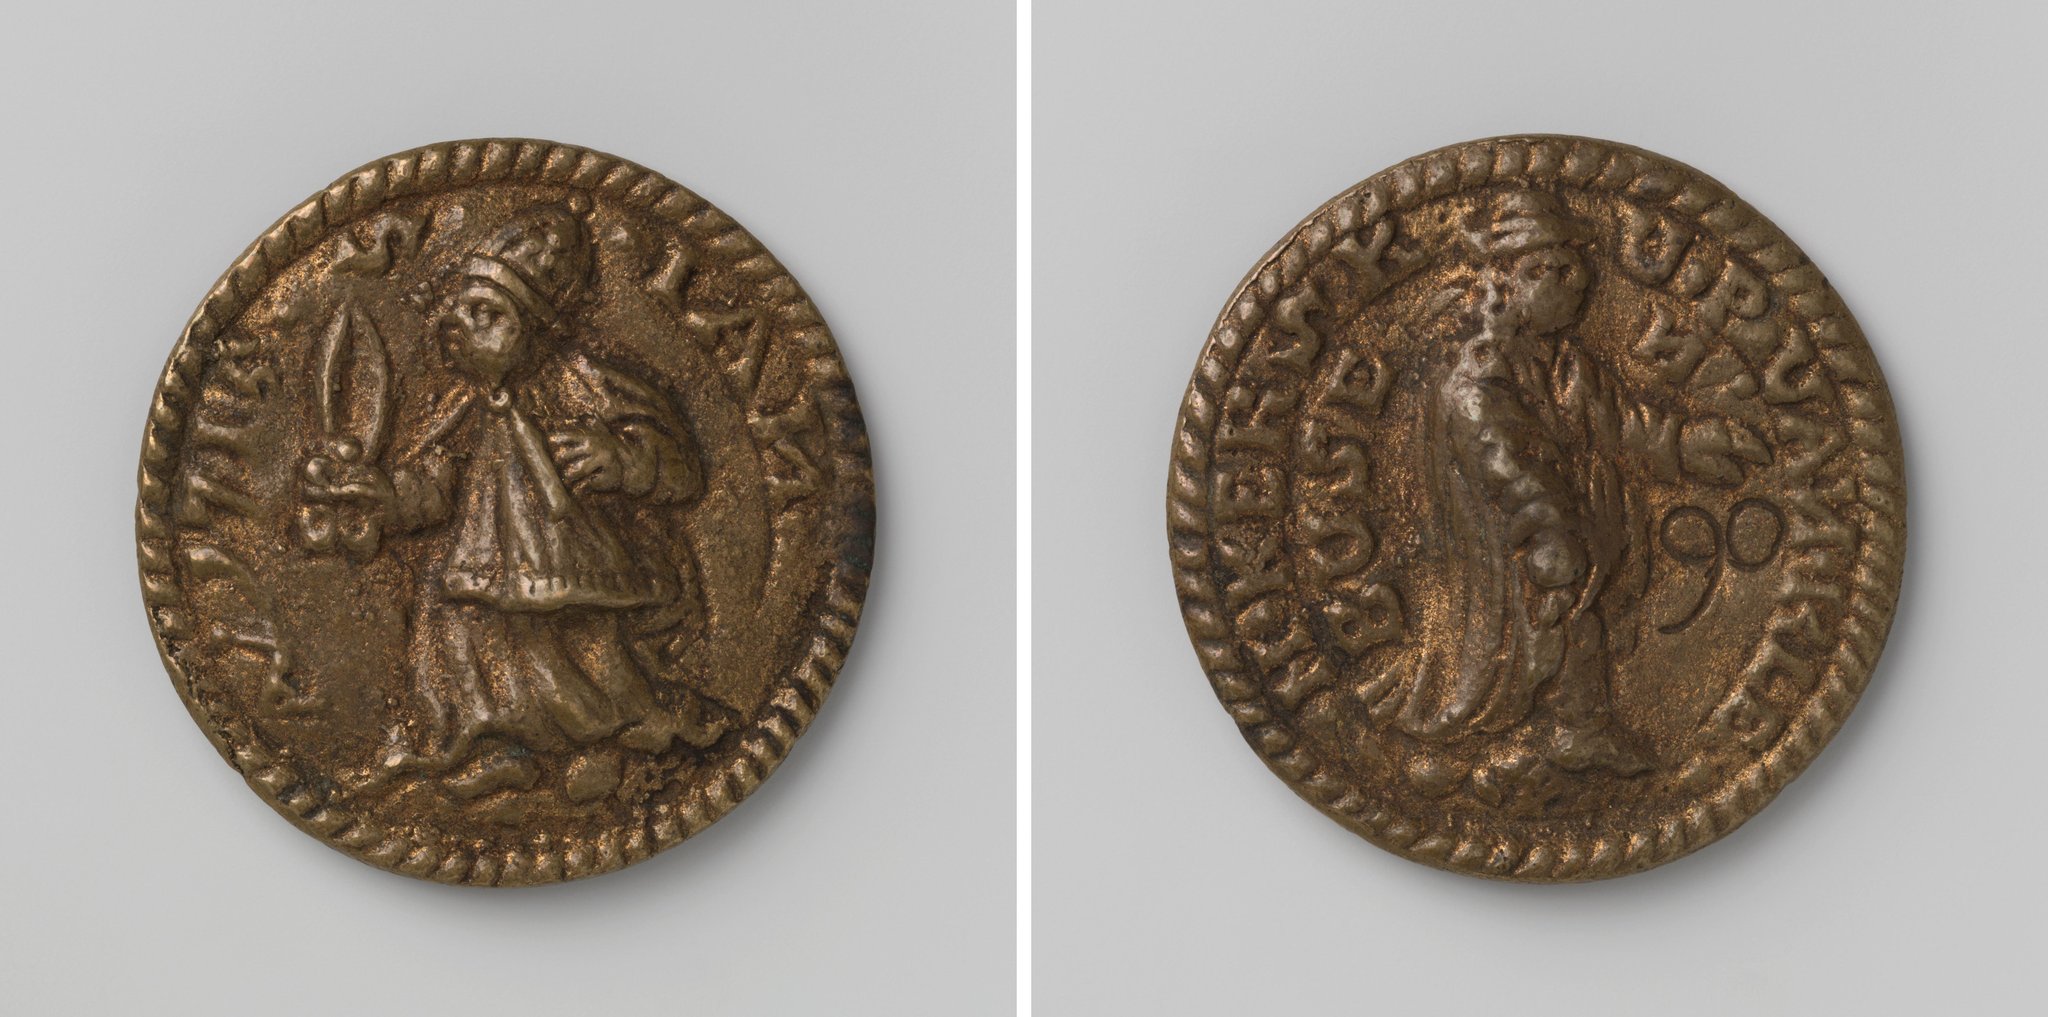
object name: medal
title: Begrafenisbus van de knechts van het kleermakersgilde van 's-Gravenhage, buspenning met no. 90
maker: Anonymous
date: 1715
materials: brass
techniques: casting, engraving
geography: the hague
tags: the hague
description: Messing penning. Voorzijde: naar links gewende bisschop St. Jan met omhoog gestoken, geopende schaar in rechterhand binnen omschrift. Keerzijde: naar rechts gewende man in rouwkleed met uitgestrekte linkerhand binnen tweeregelig omschrift; in veld rechts onder: cijfer 90